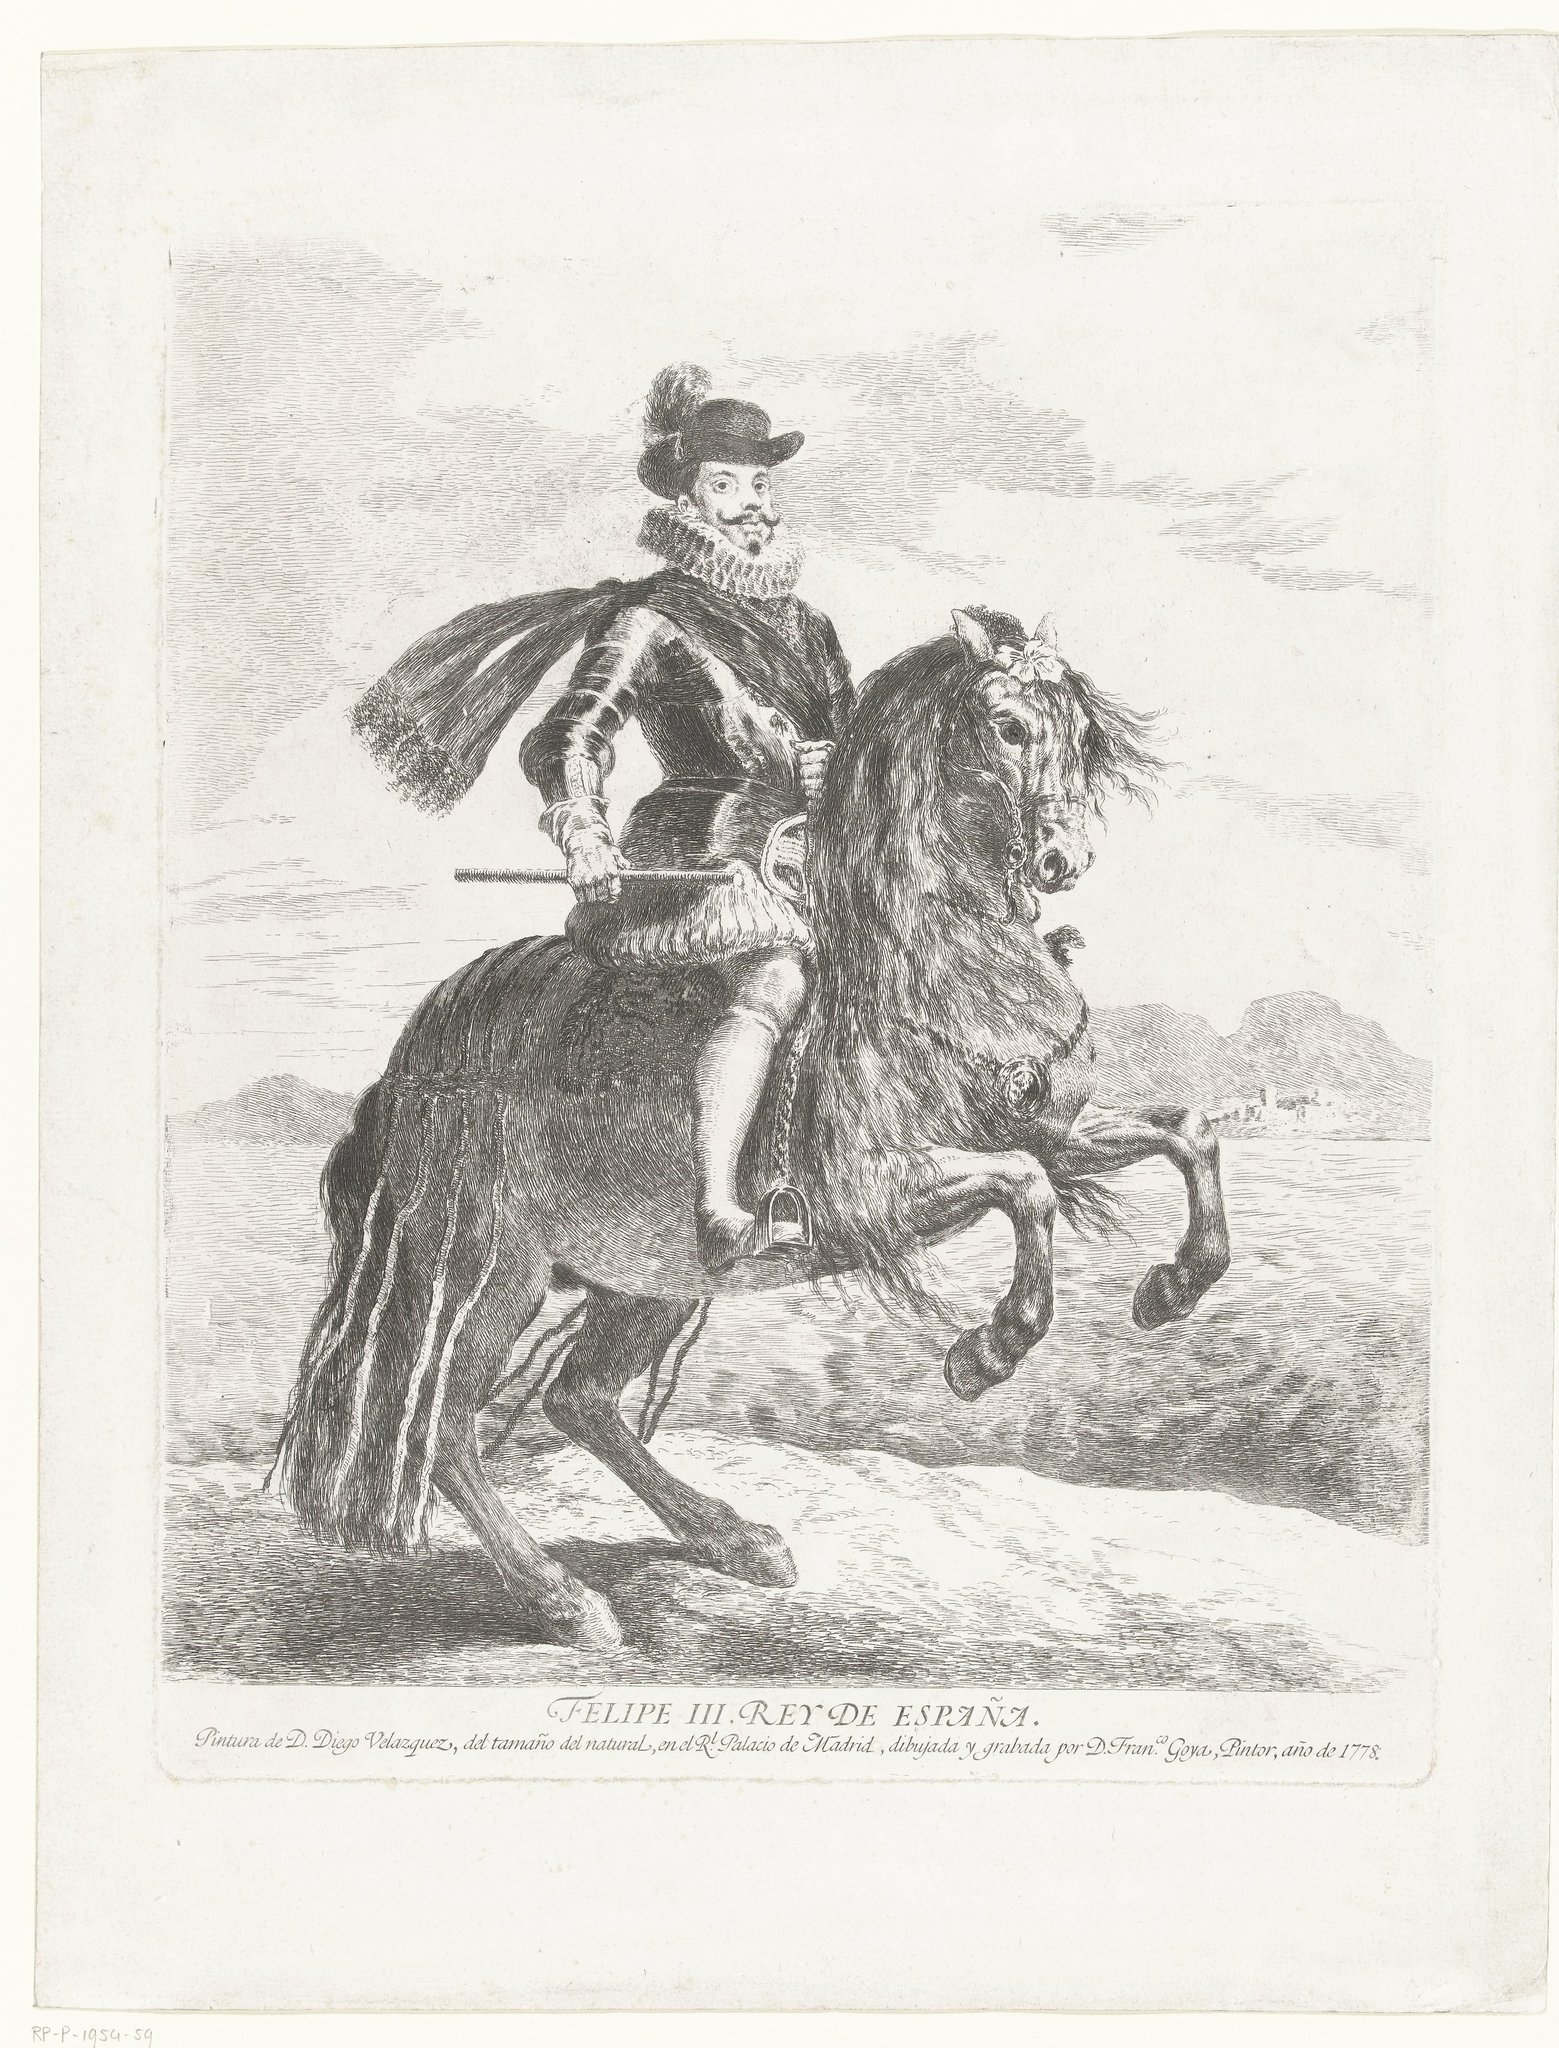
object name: print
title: Portret van Filips III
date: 1778-1779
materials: paper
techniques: drypoint, etching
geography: spain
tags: filips iii (koning van spanje), equestrian state-portrait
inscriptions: collector's mark: Lugt 2237a, collector's mark: Lugt 2760, collector's mark: Lugt 2228, collector's mark: Lugt 2926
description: Ruiterportret van Filips III, koning van Spanje.